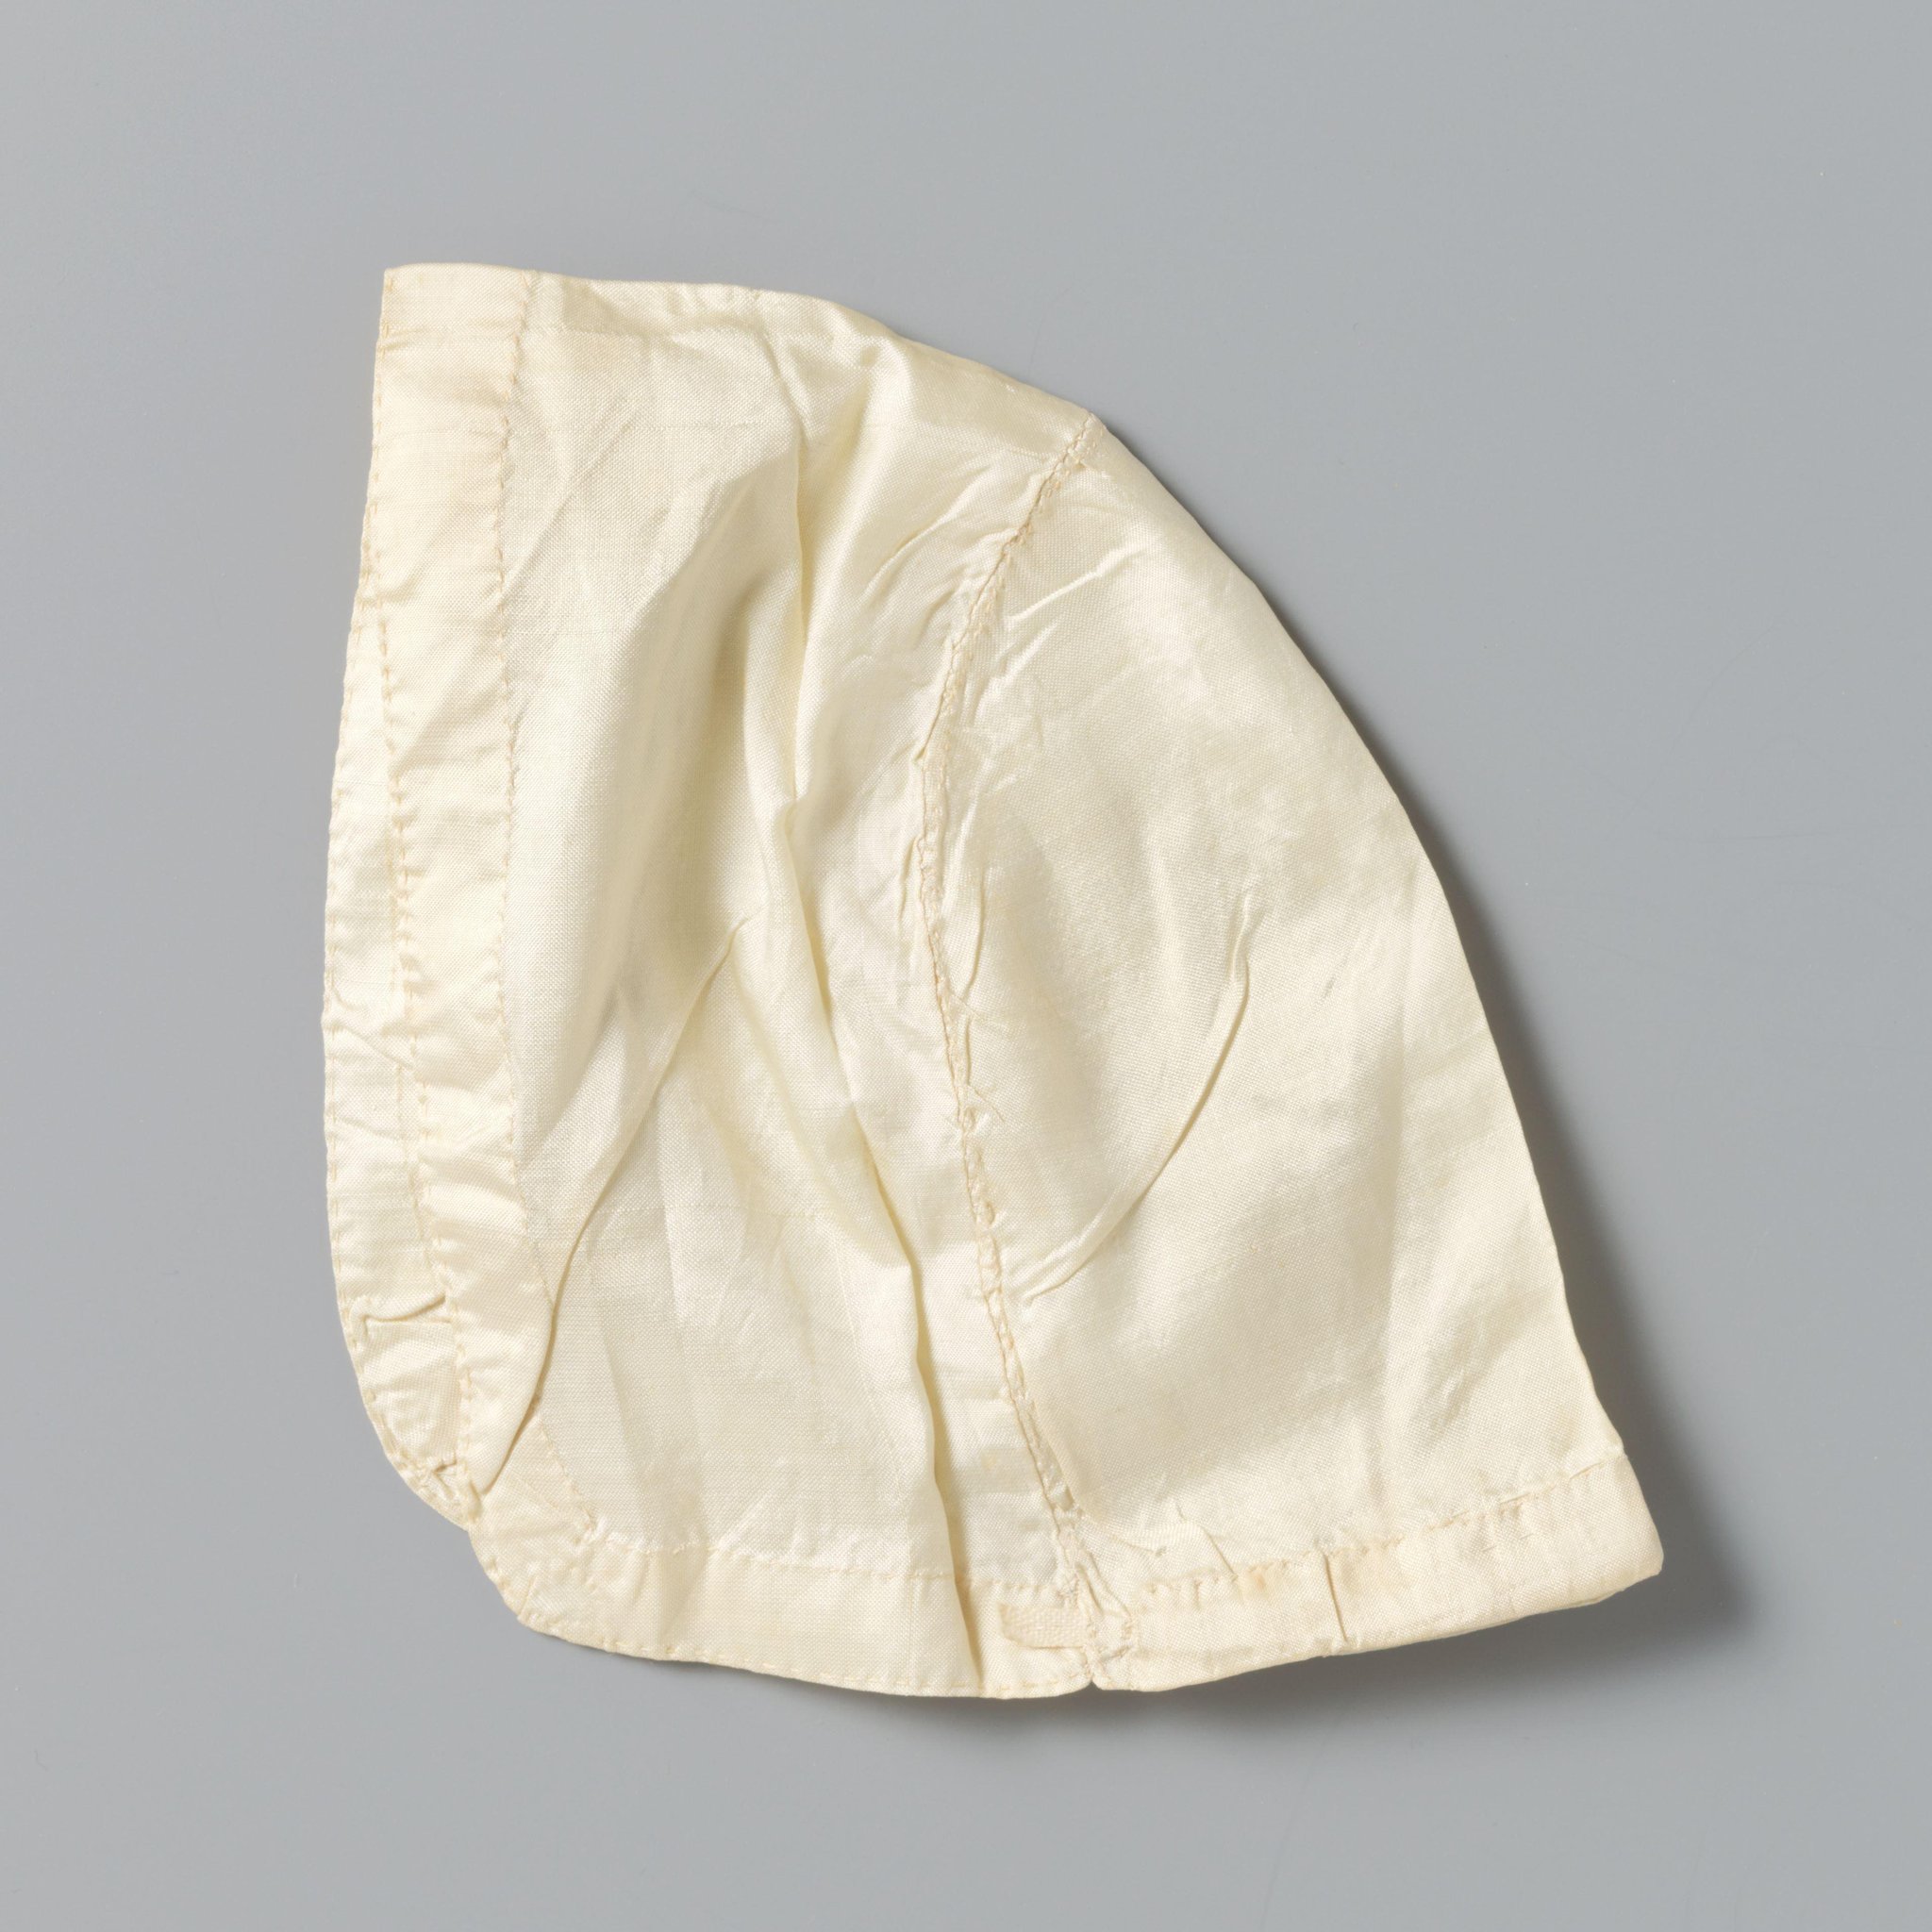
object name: hoofddeksel, hoofdbedekking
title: Ondermuts van crème zijde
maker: Anonymous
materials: silk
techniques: lace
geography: europe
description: Een zijden mutsvoering behoorende bij een muts van kloskant (Mâlines met geplooiden rand.